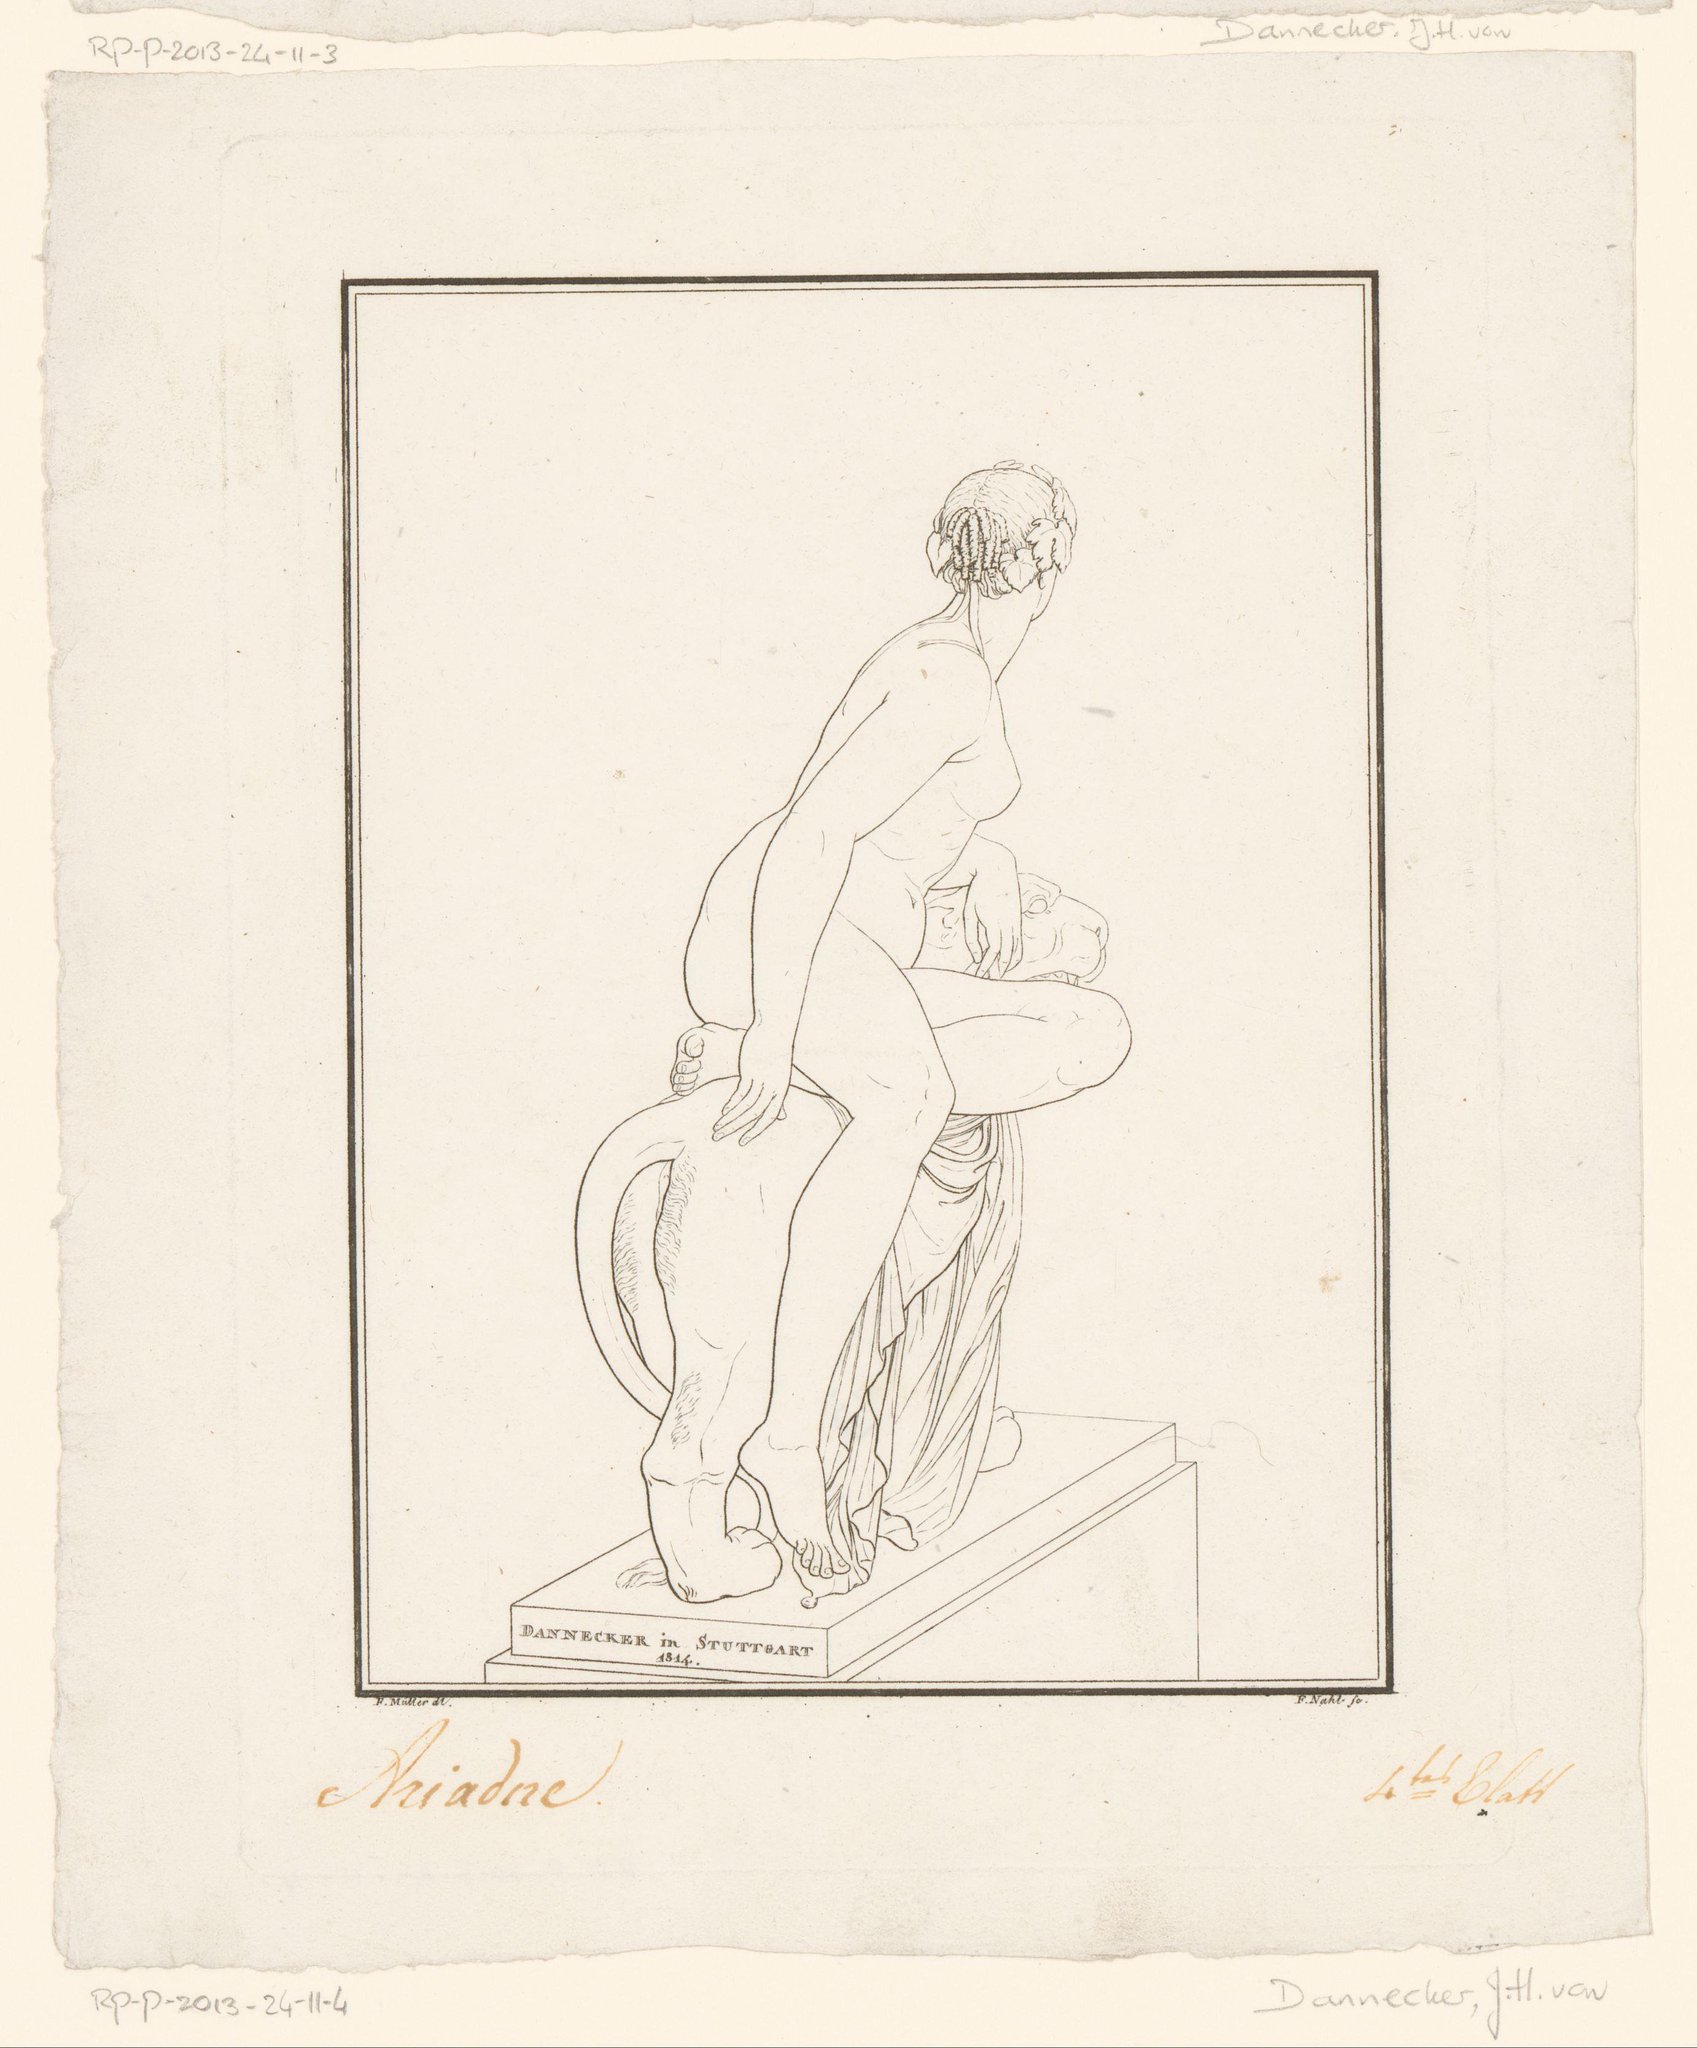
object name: print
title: Aanzichten van het beeld van Heinrich von Dannecker van Ariadne op de panter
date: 1814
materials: paper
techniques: engraving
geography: germany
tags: ariadne left behind on the island of naxos, (story of) ariadne and bacchus, piece of sculpture, reproduction of a piece of sculpture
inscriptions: collector's mark: Lugt 2228, inscription: ‘Ariadne // 4tes Blatt’, collector's mark: Lugt 2760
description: Onderdeel van een serie van vier verschillende aanzichten van het beeldhouwwerk van Heinrich von Dannecker voorstellend Ariadne zittend op de panter. Het beeld bevindt zich nu in het Liebieghaus Skulpturensammlung, Frankfurt am Main.